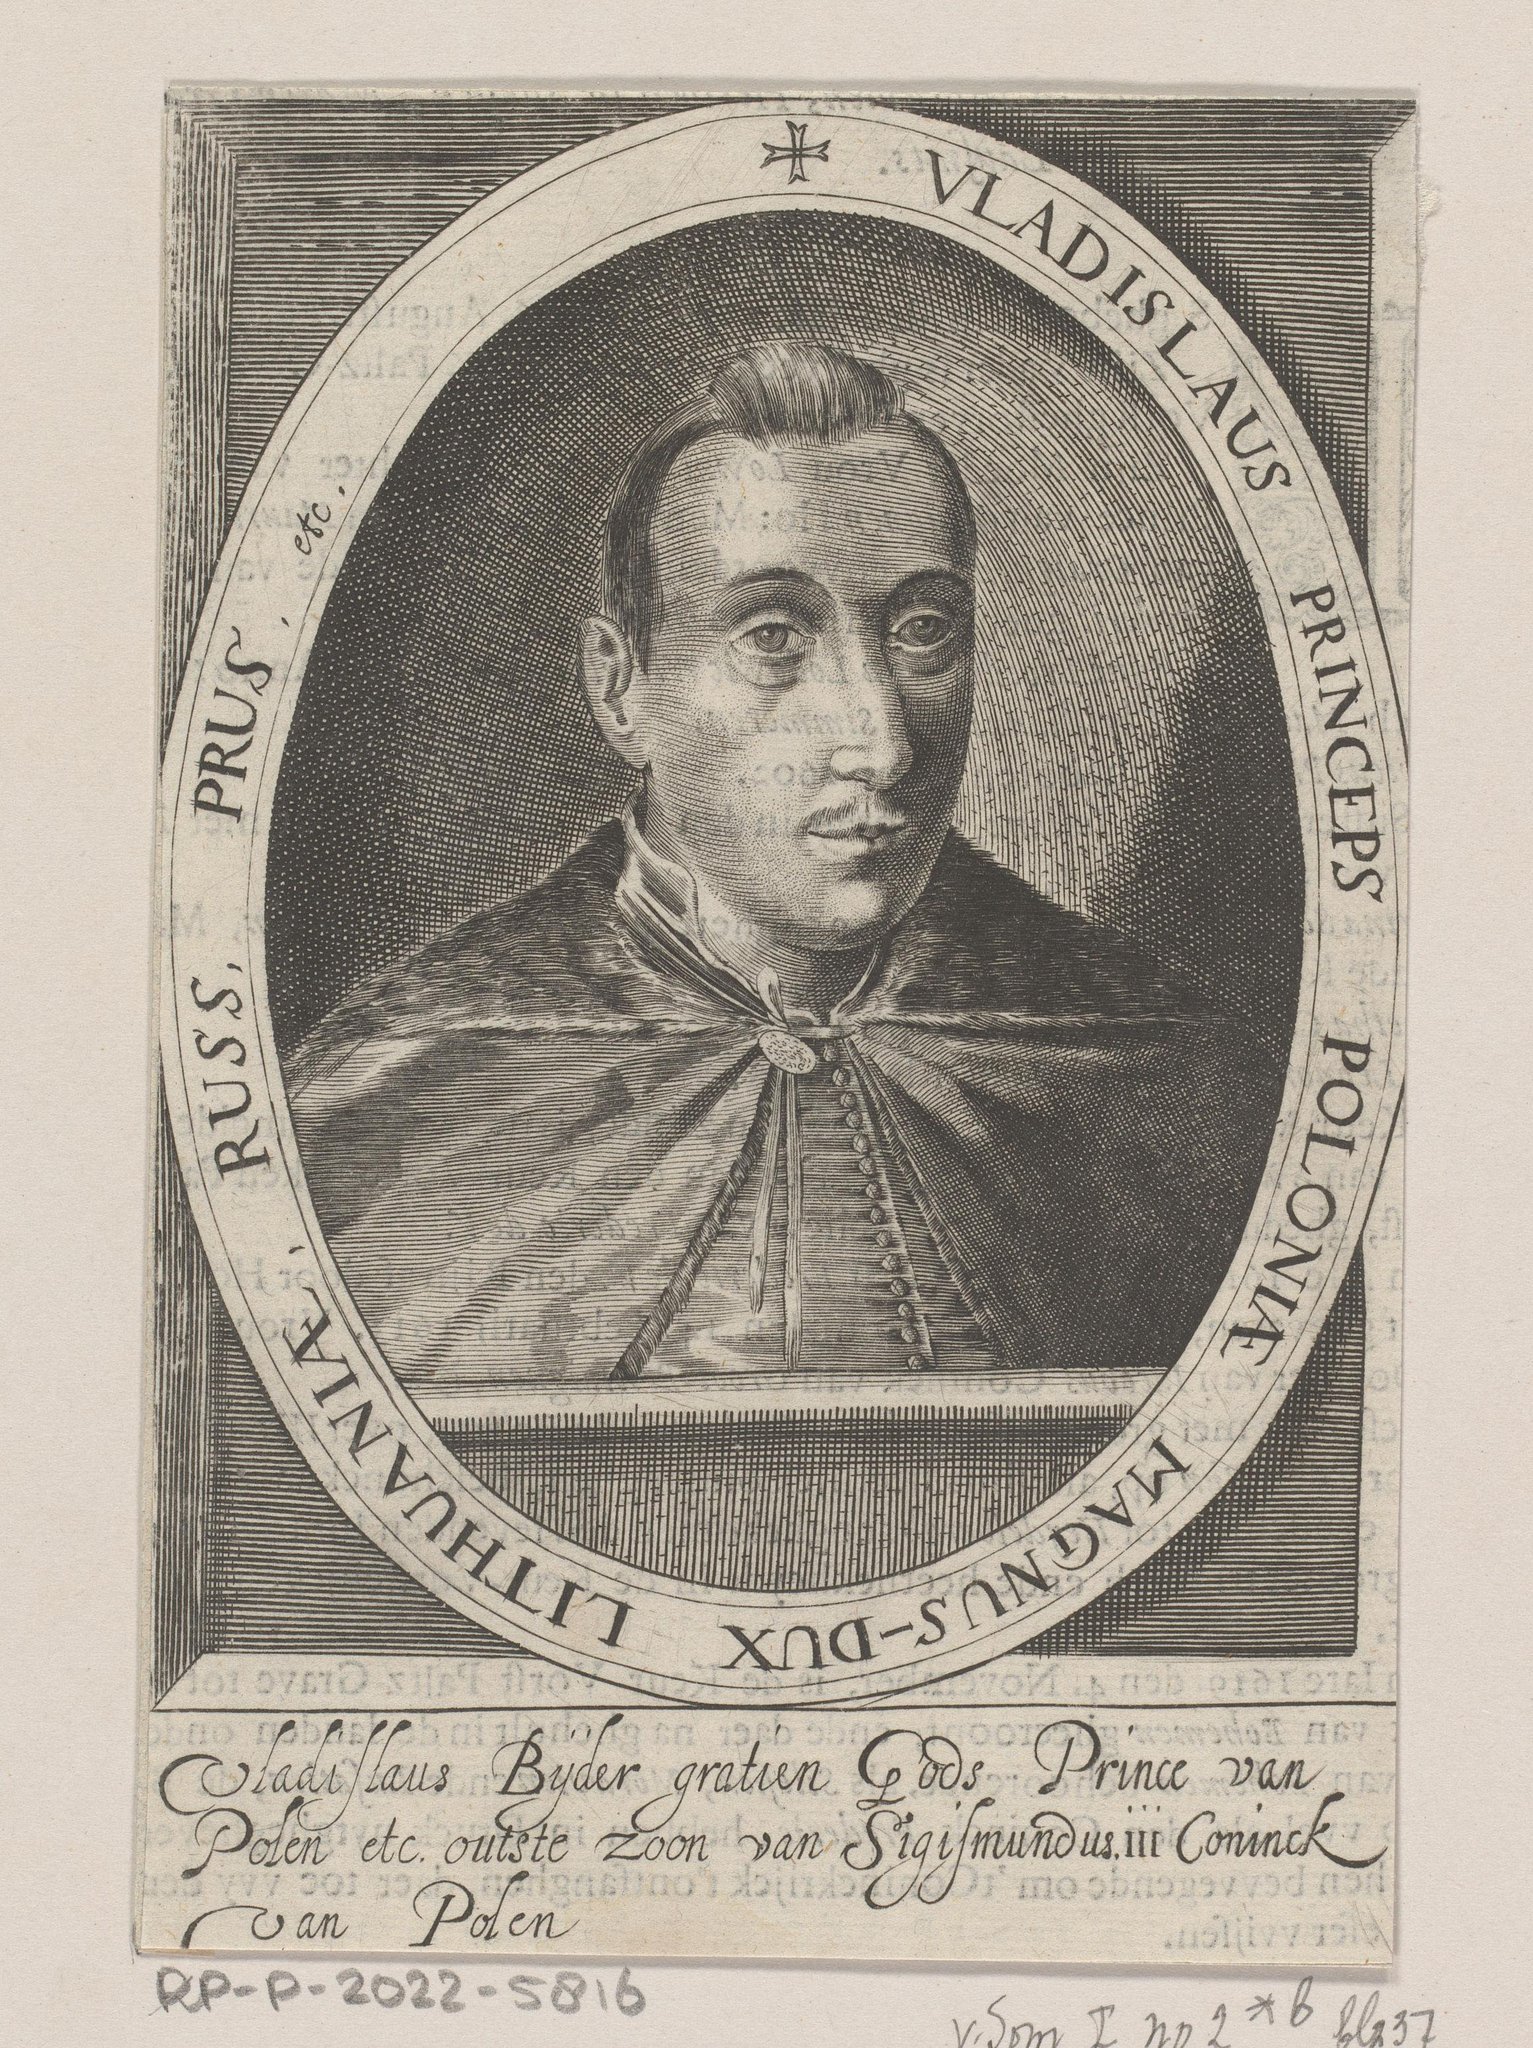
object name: print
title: Portret van Wladislaus IV van Polen als kroonprins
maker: Anonymous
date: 1625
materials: paper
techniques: engraving, letterpress printing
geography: delft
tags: wladislaus wasa (iv), historical persons, ruler, sovereign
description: Prent uit: Clerck, Nicolaes de. Princelyck Cabinet, Verthoonende T'leven Afcomste ende afbeeldingen der voornaemste Vorste (...). Delft: erven Nicolaes de Clerck, 1625. p. 37.